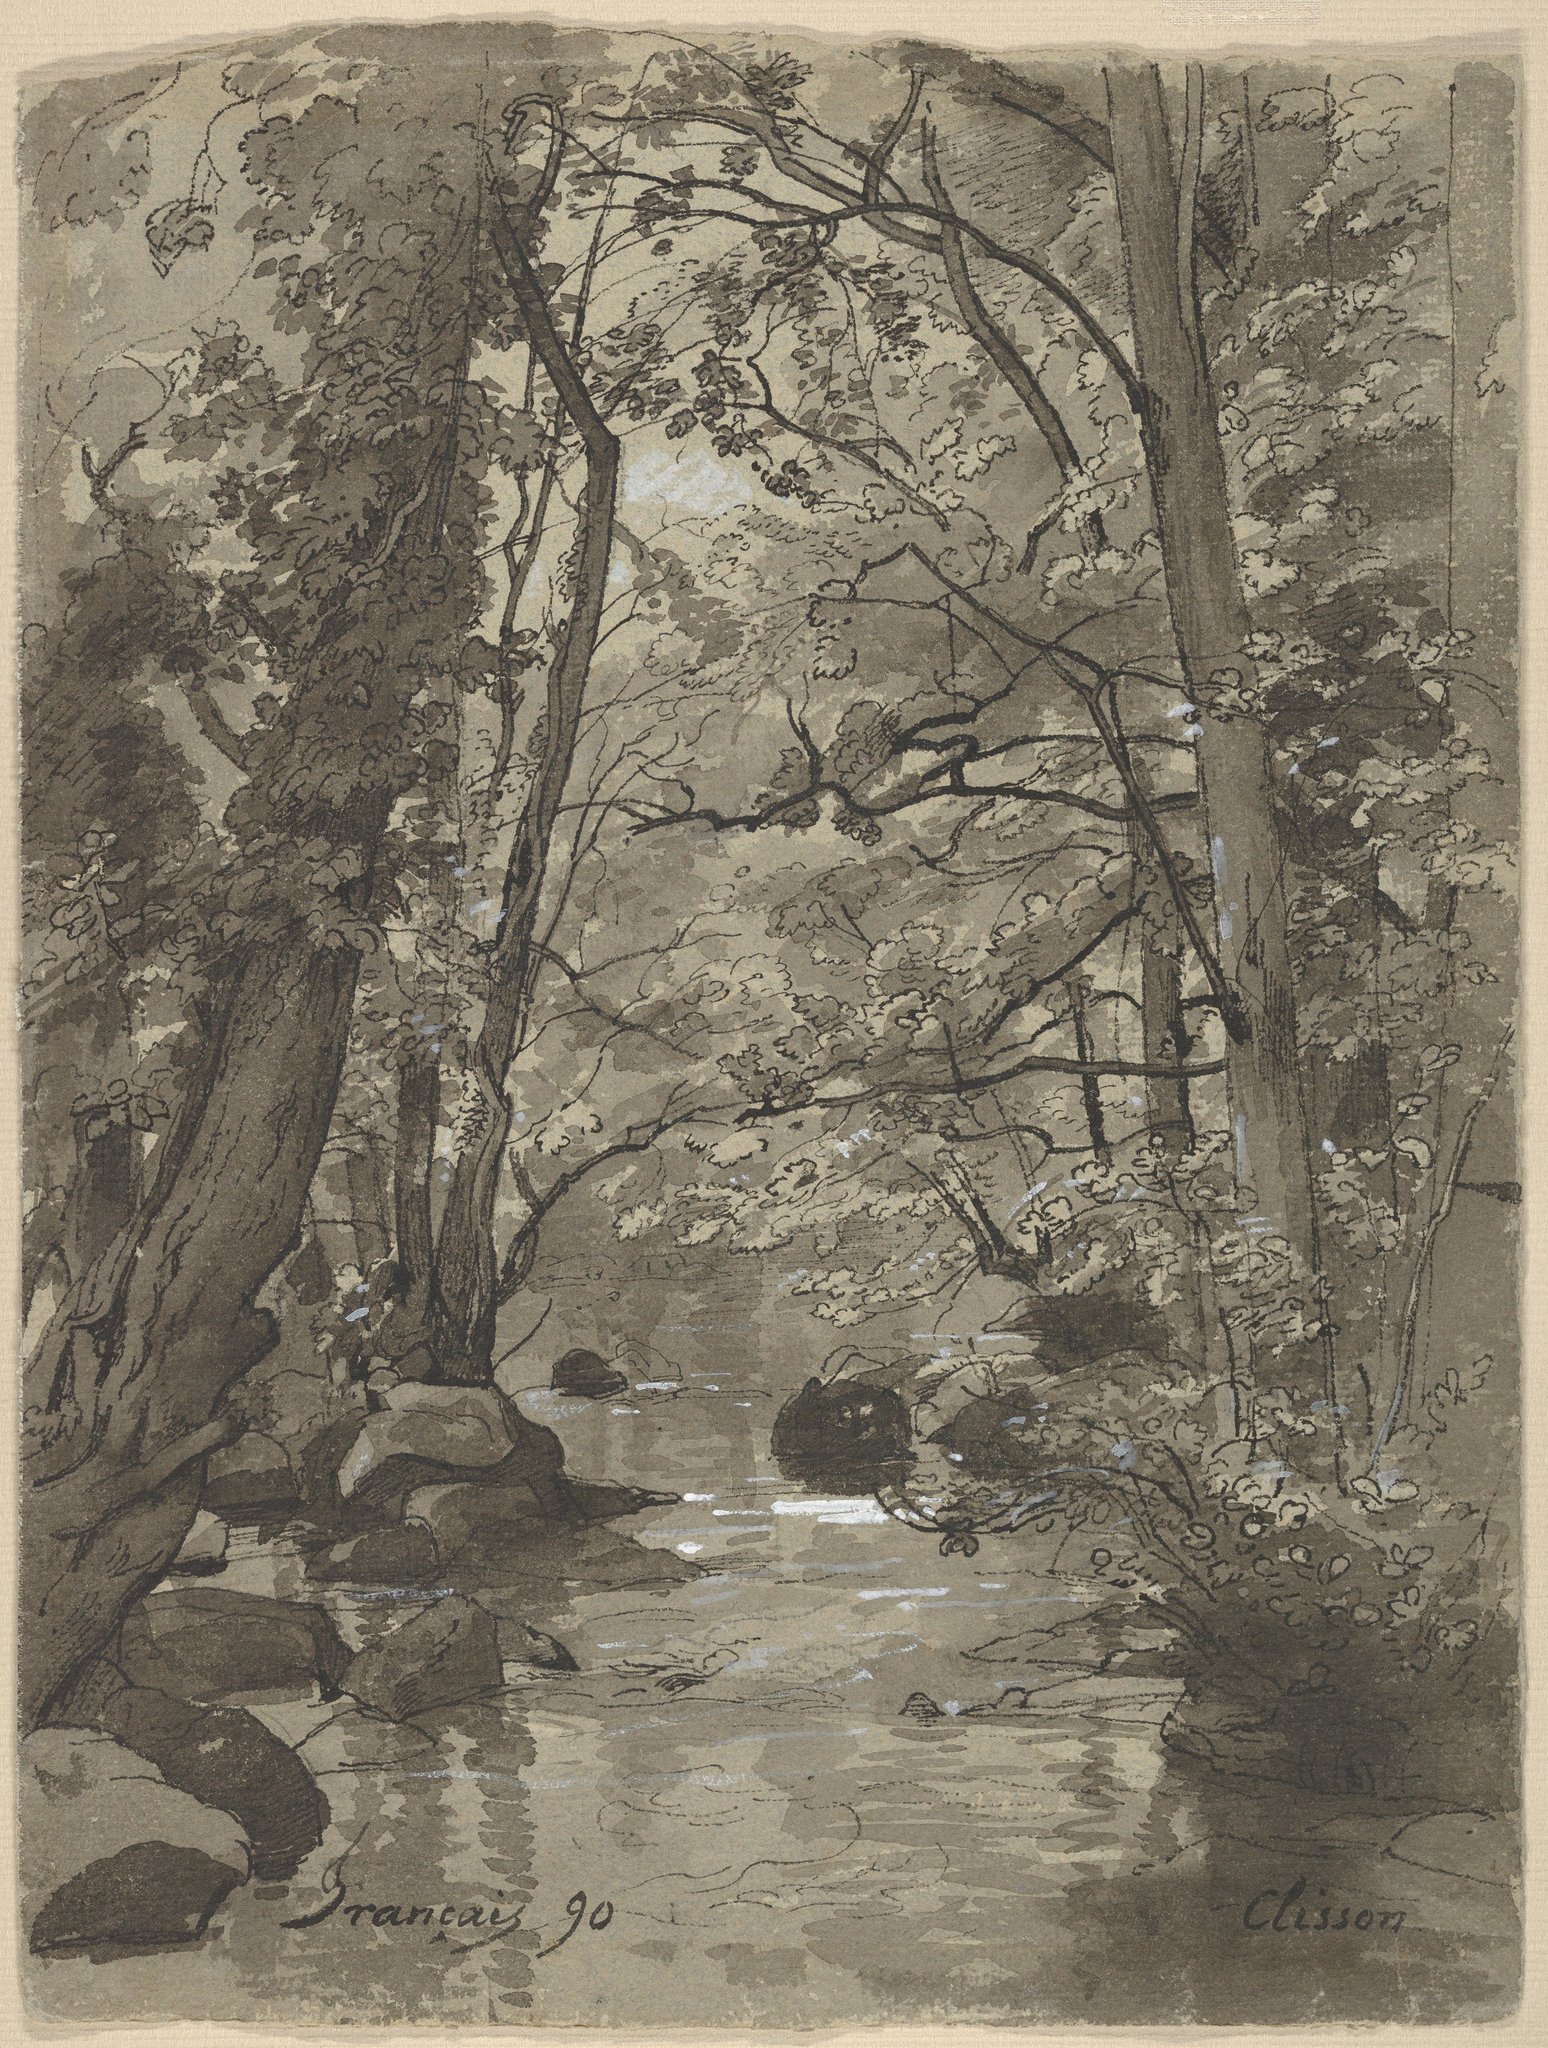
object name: drawing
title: Forest at Clisson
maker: françois-louis français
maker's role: artist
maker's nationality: french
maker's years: 1814-1897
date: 1890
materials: ink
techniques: brush, heightening, pen, wash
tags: forests